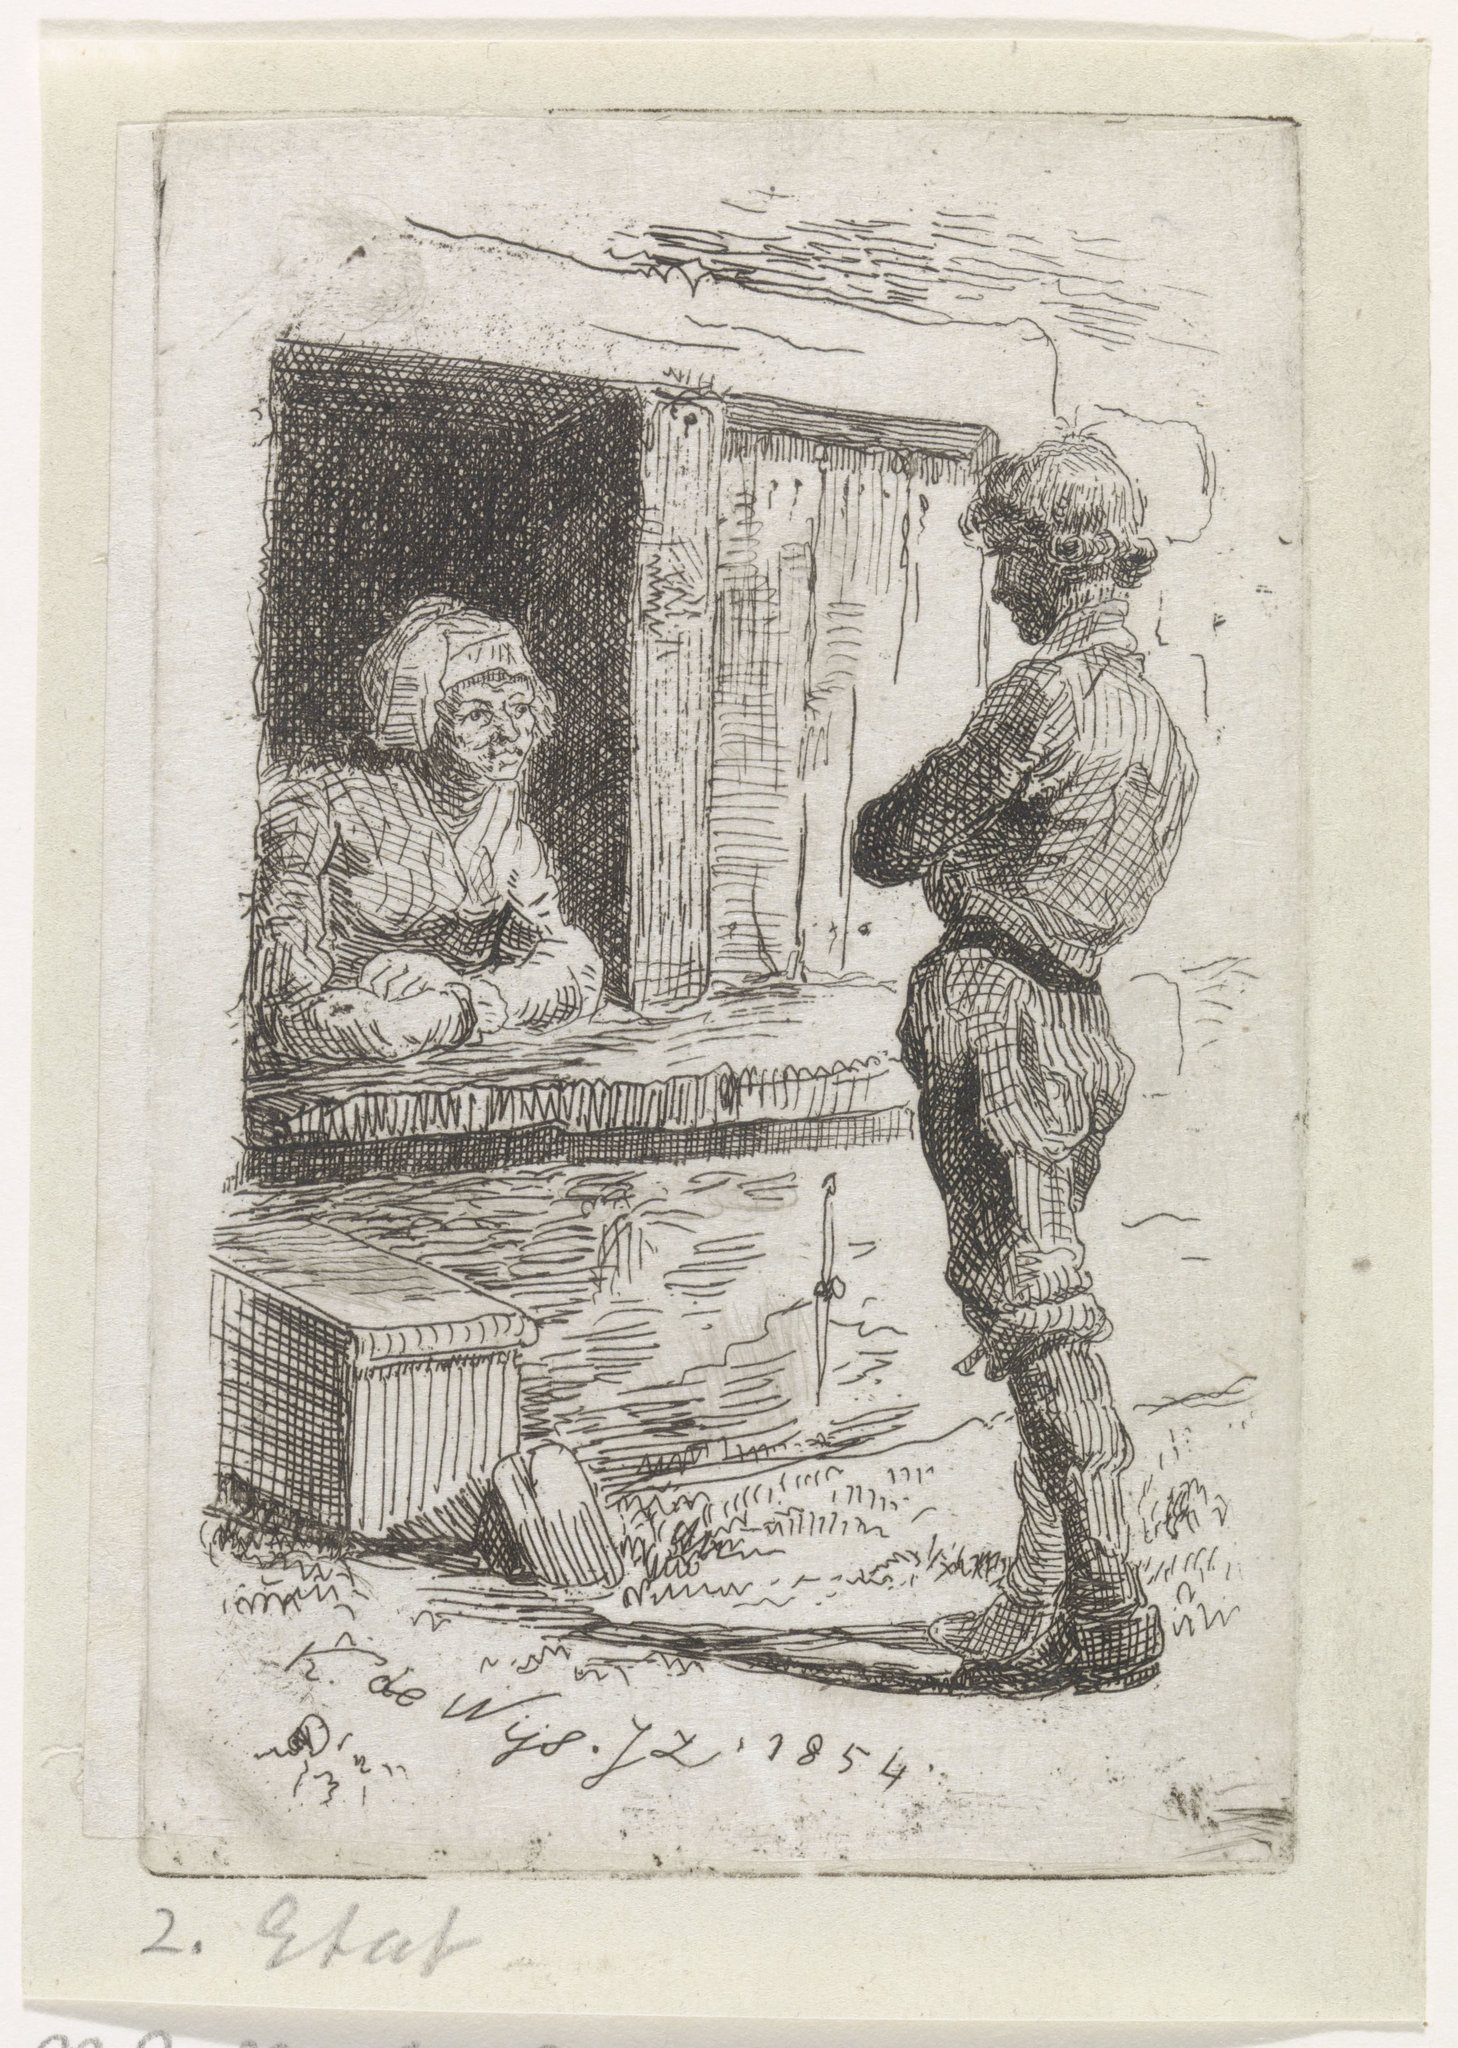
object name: print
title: Gesprek aan het venster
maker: kornelis jzn de wijs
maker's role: print maker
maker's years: 1832-1896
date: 1854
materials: paper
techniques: etching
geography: the hague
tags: neighbour, conversation, dialogue; conversation piece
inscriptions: collector's mark: Lugt 2228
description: Een voorbijganger spreekt met een vrouw, die aan haar raam zit.